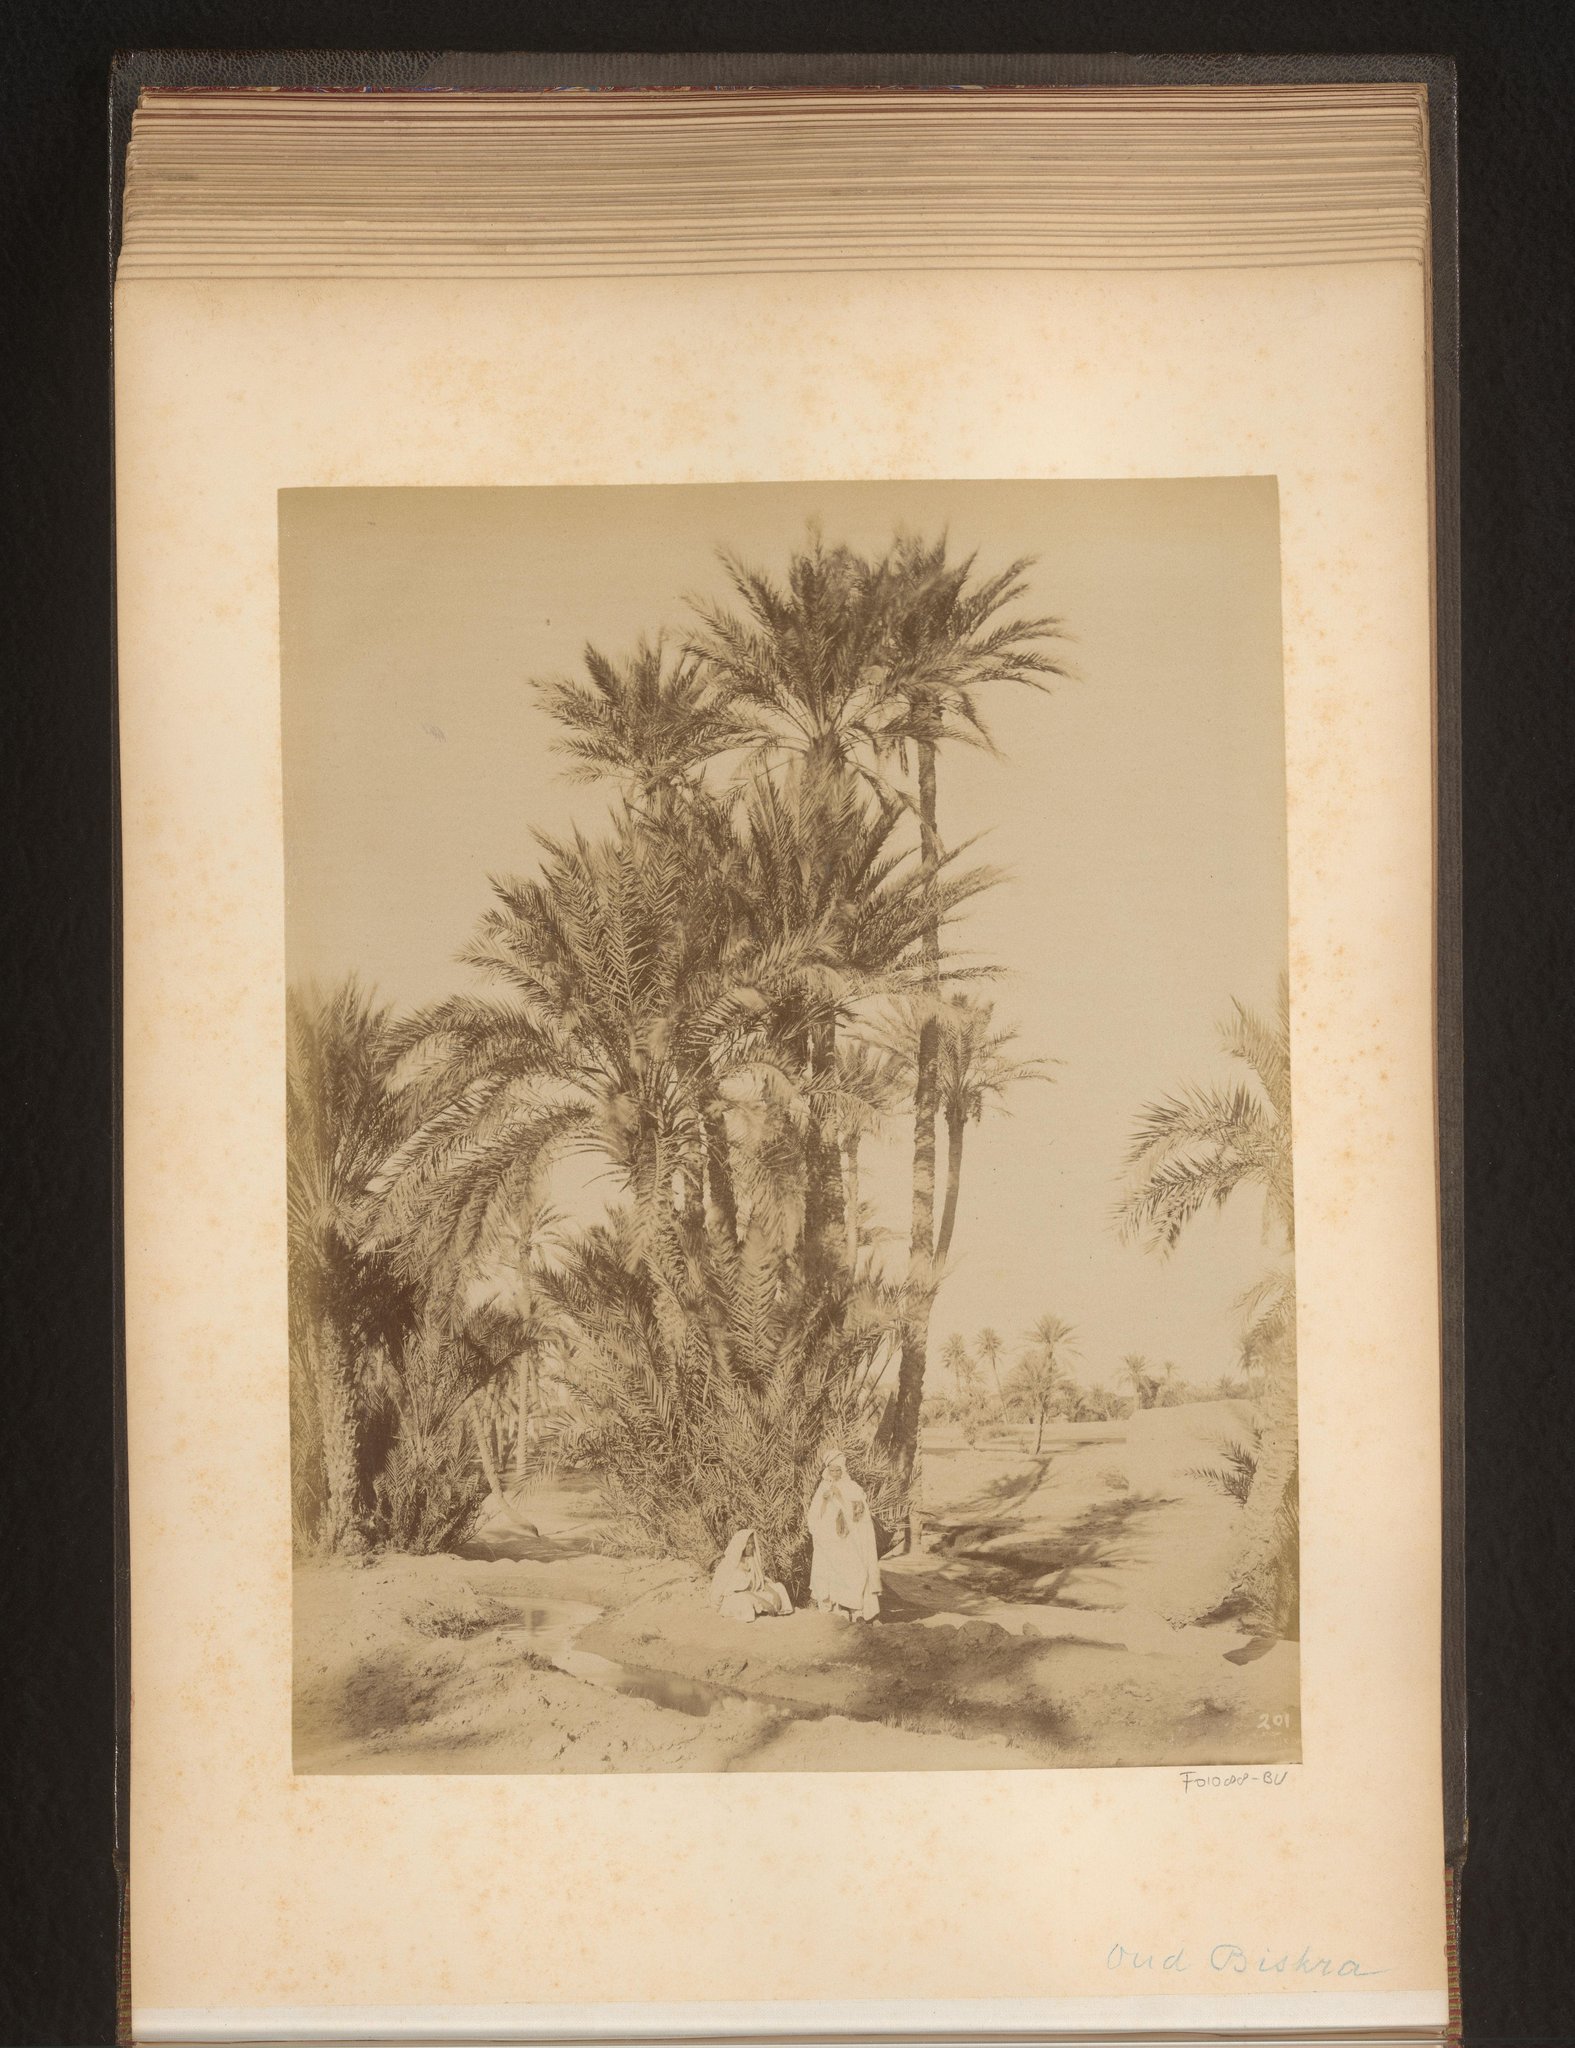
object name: album leaf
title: Twee personen onder palmbomen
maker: Anonymous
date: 1880-1900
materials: photographic support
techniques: albumen print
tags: historical persons, landscapes with waters, waterscapes, seascapes (in the temperate zone), trees: palm-tree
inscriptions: number: ‘201’